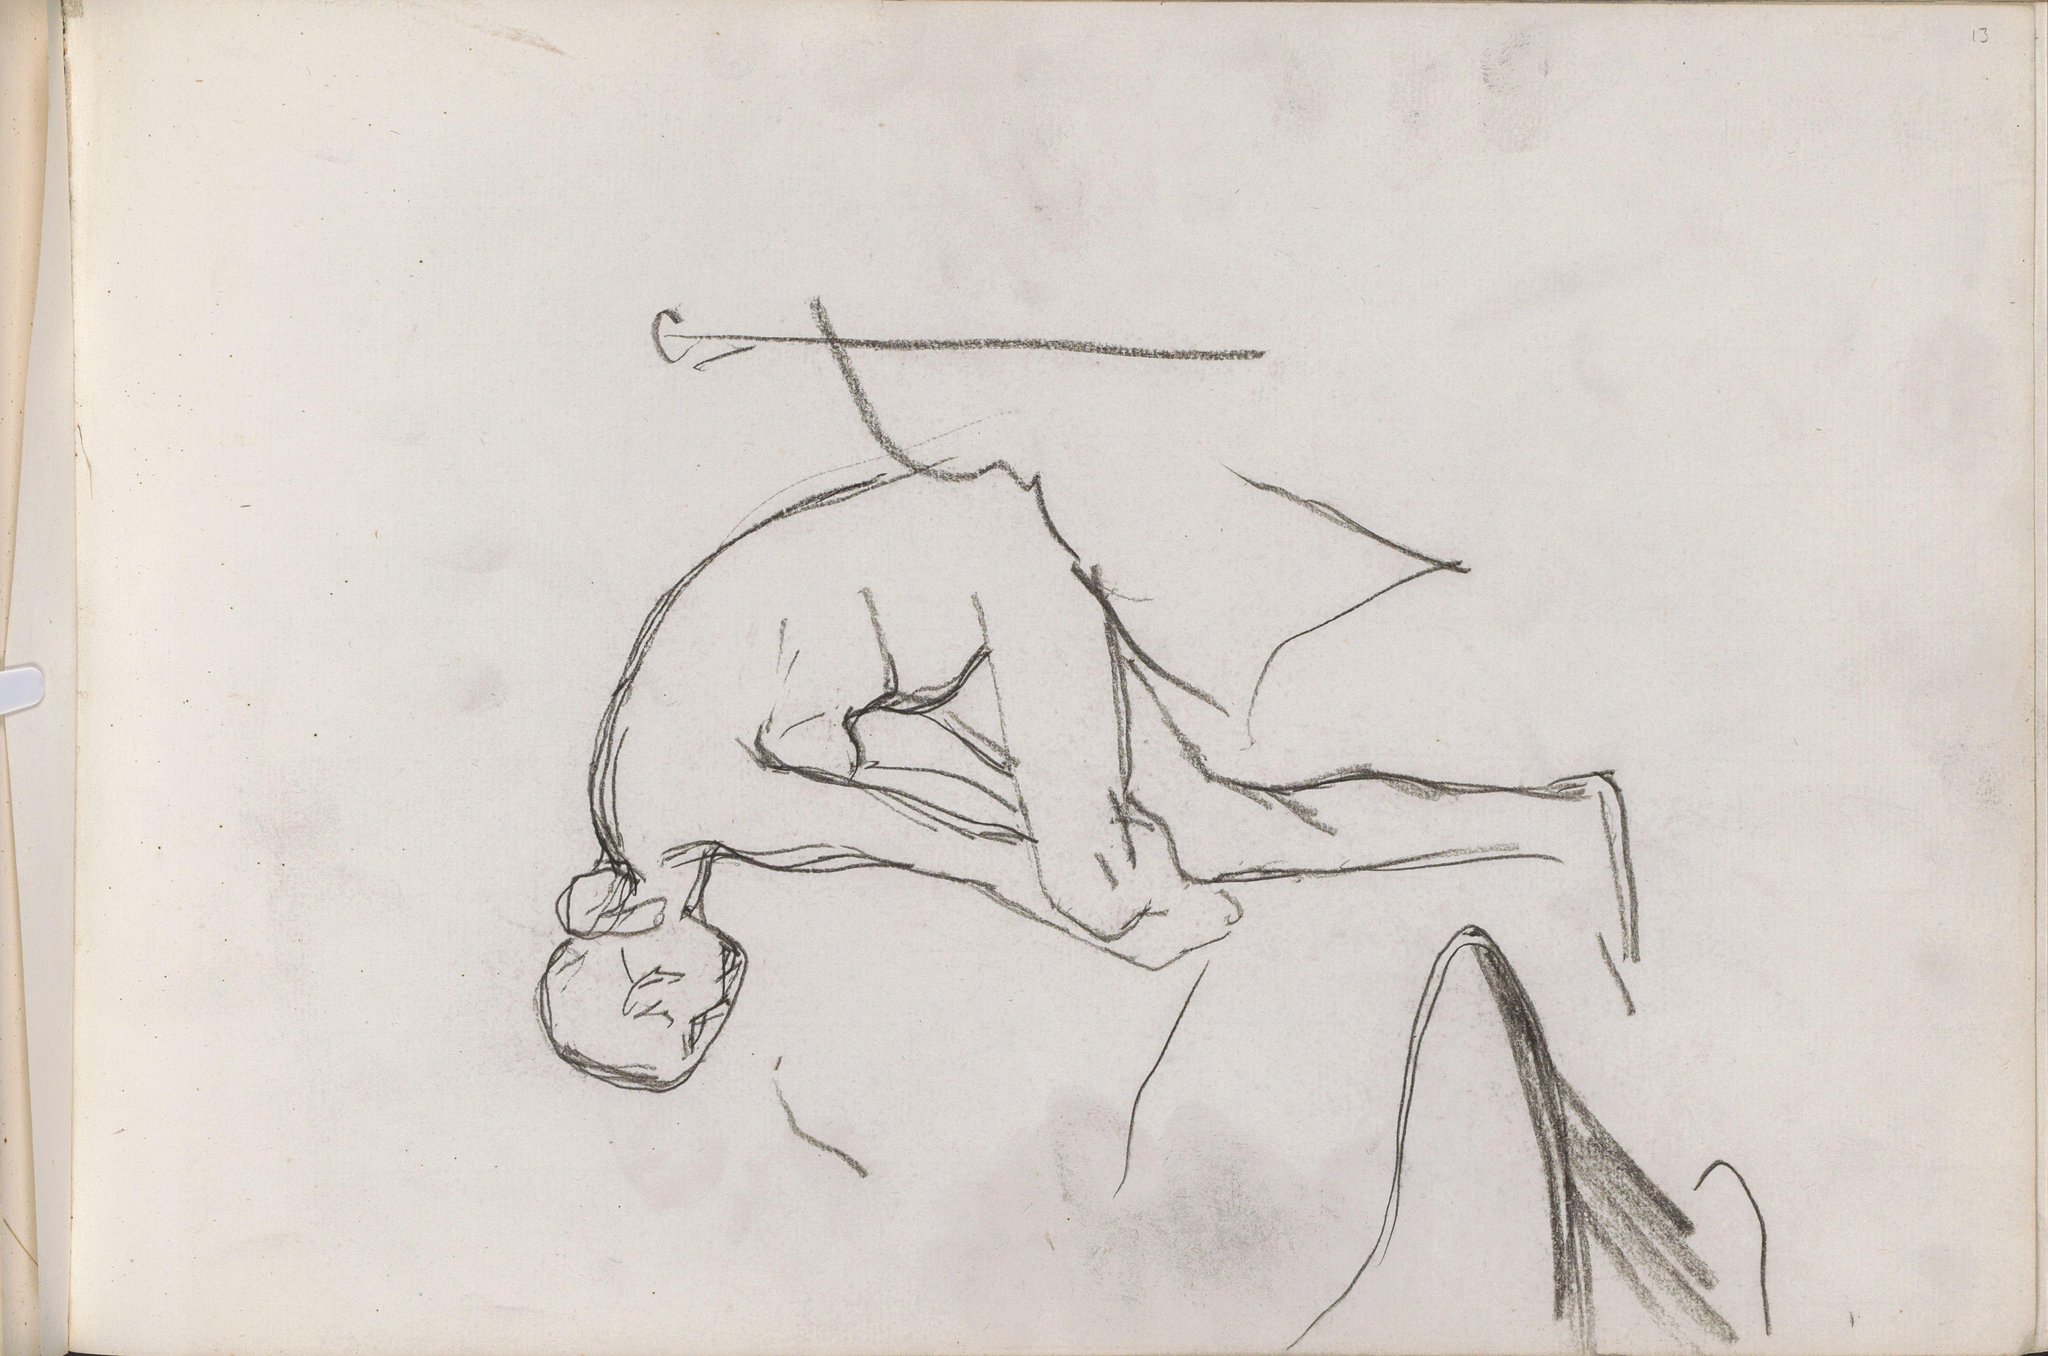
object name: sketchbook leaf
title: Vrouwelijk naakt op een bedrand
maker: willem witsen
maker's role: draughtsman, painter, print maker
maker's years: 1860-1923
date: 1887-1892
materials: chalk, paper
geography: amsterdam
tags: the (nude) human figure; 'corpo humano' (ripa) - aa - female human figure (+ sitting), bed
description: De vrouw zit met een been opgetrokken. Mogelijk kleedt ze zich aan of uit. Pagina 13 uit een schetsboek met 17 bladen.